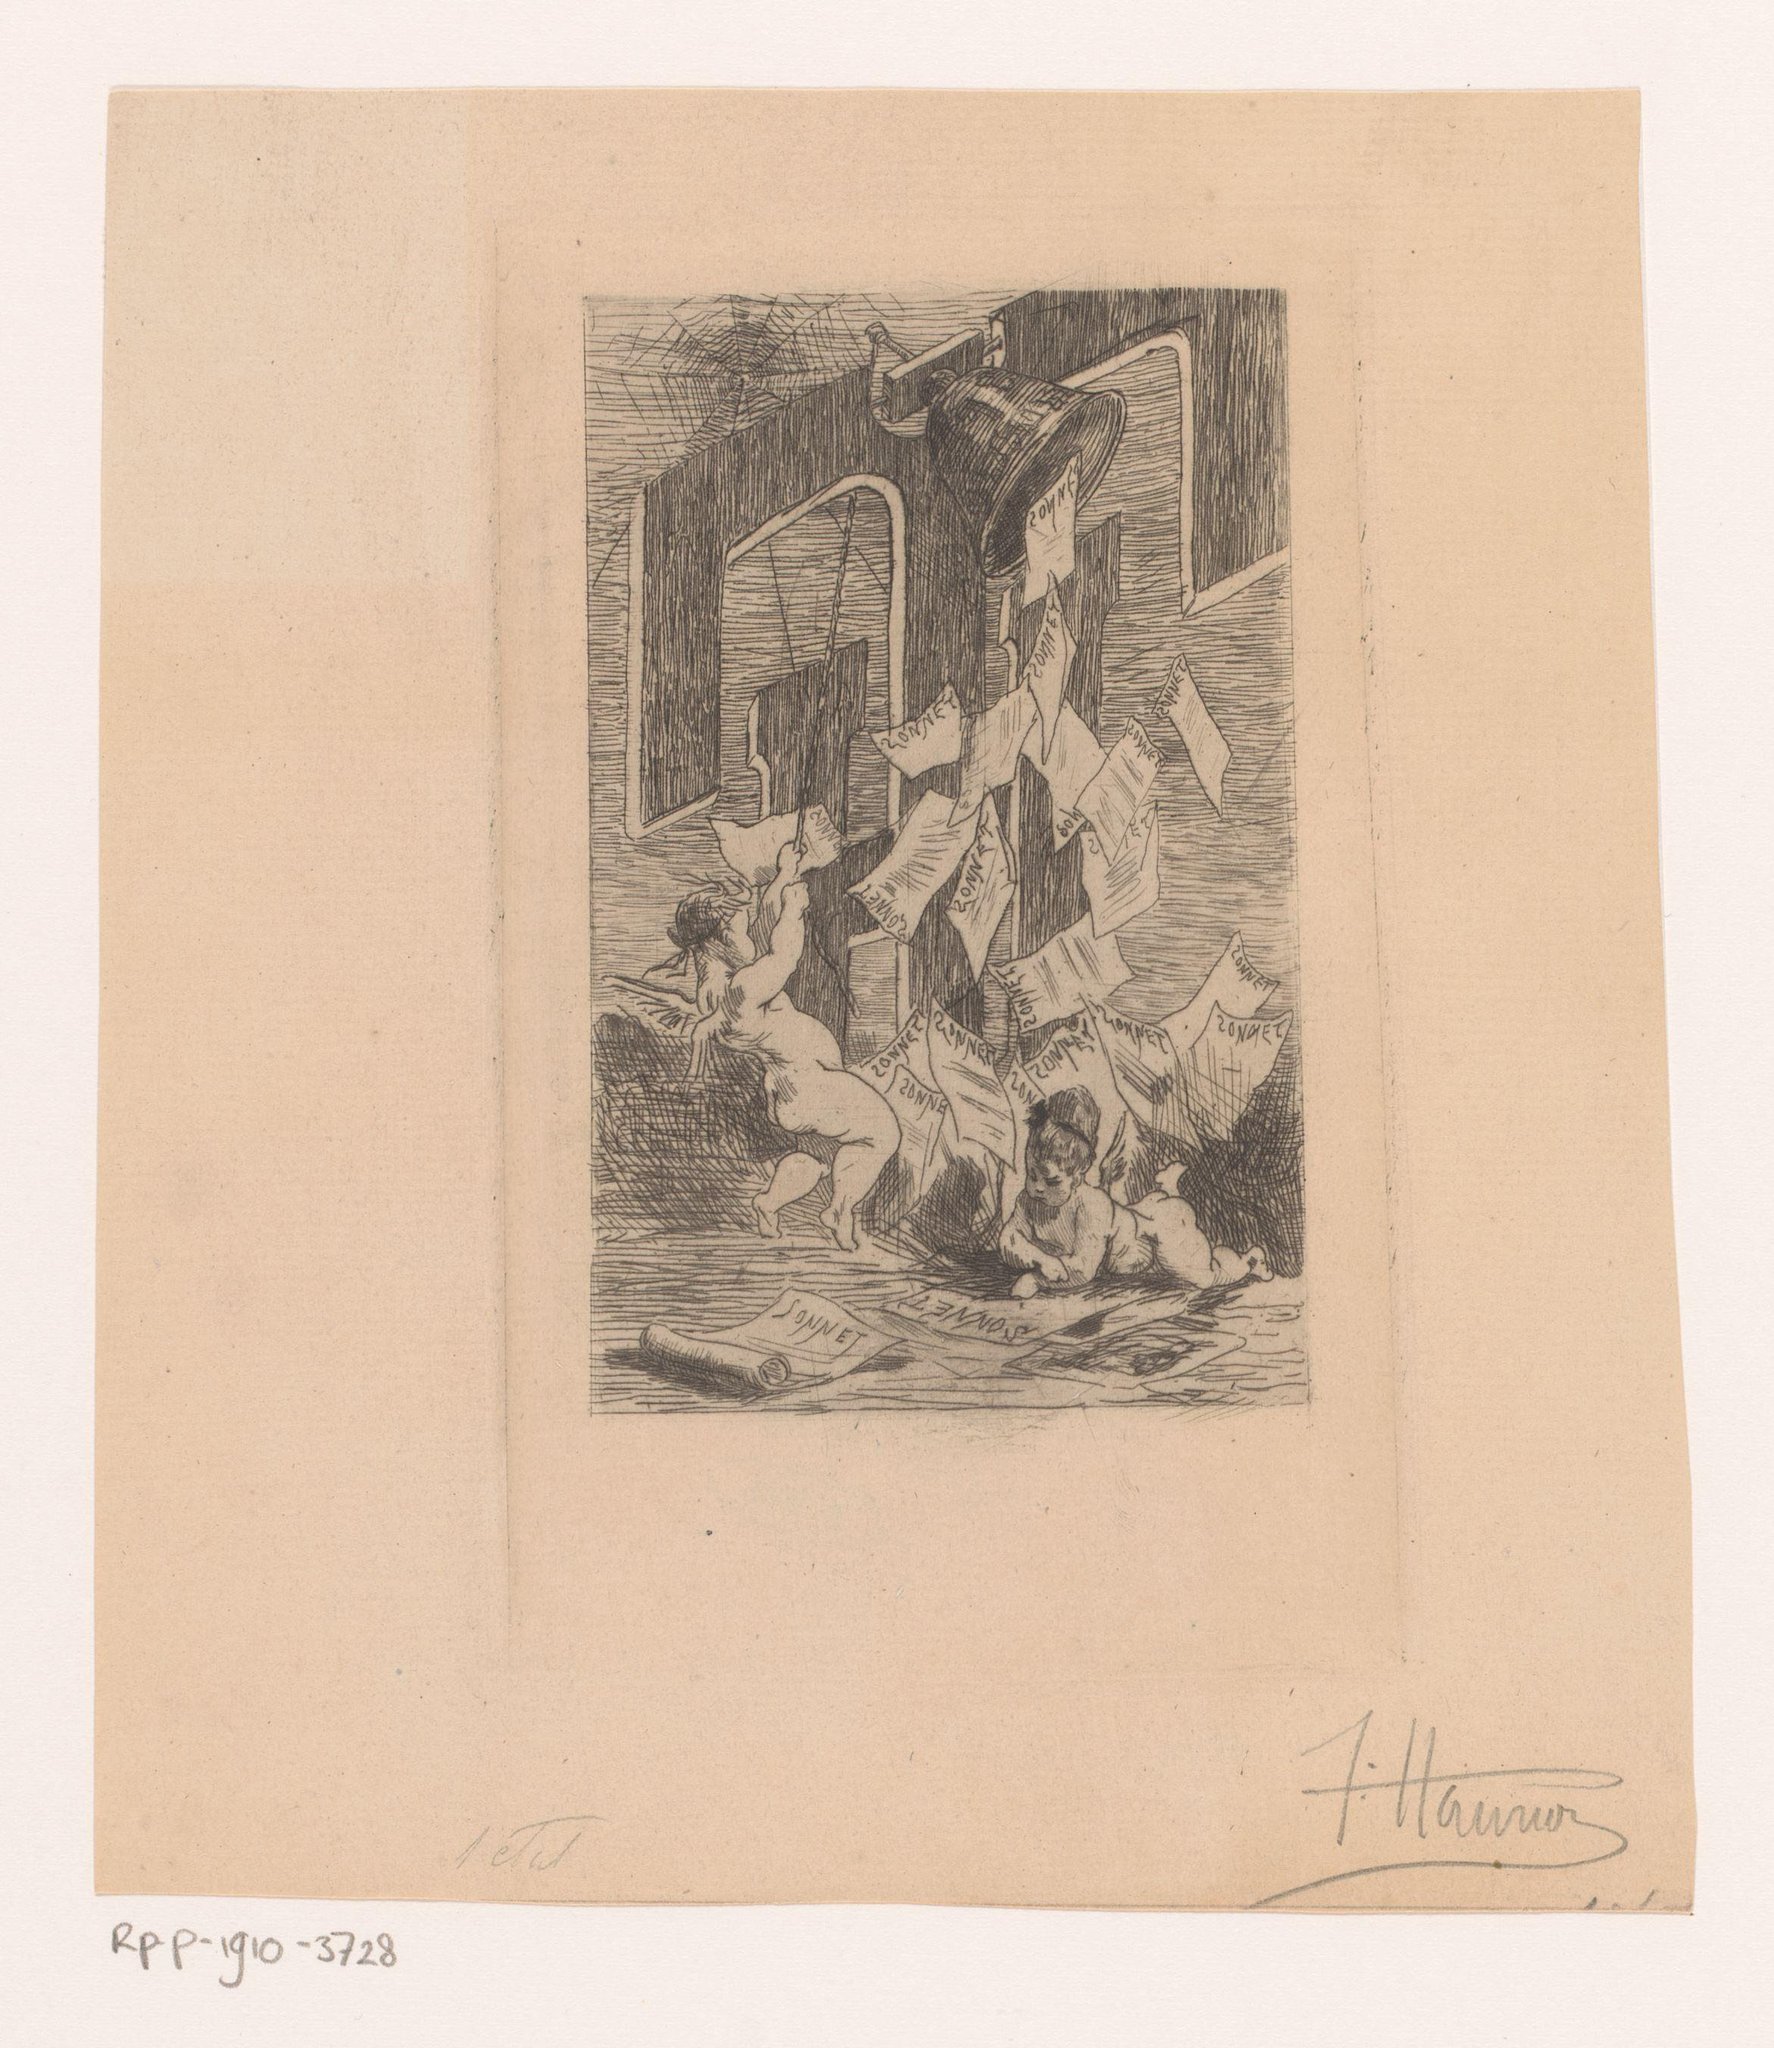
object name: print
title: Putto luidt een bel waaruit sonnetten vallen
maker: theodoor hannon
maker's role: print maker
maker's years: 1851-1917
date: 1861-1910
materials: paper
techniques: etching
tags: reading, cupids: 'amores', 'amoretti', 'putti', bell ~ acoustic signalling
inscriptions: inscription: ‘1 etat’, collector's mark: Lugt 2228